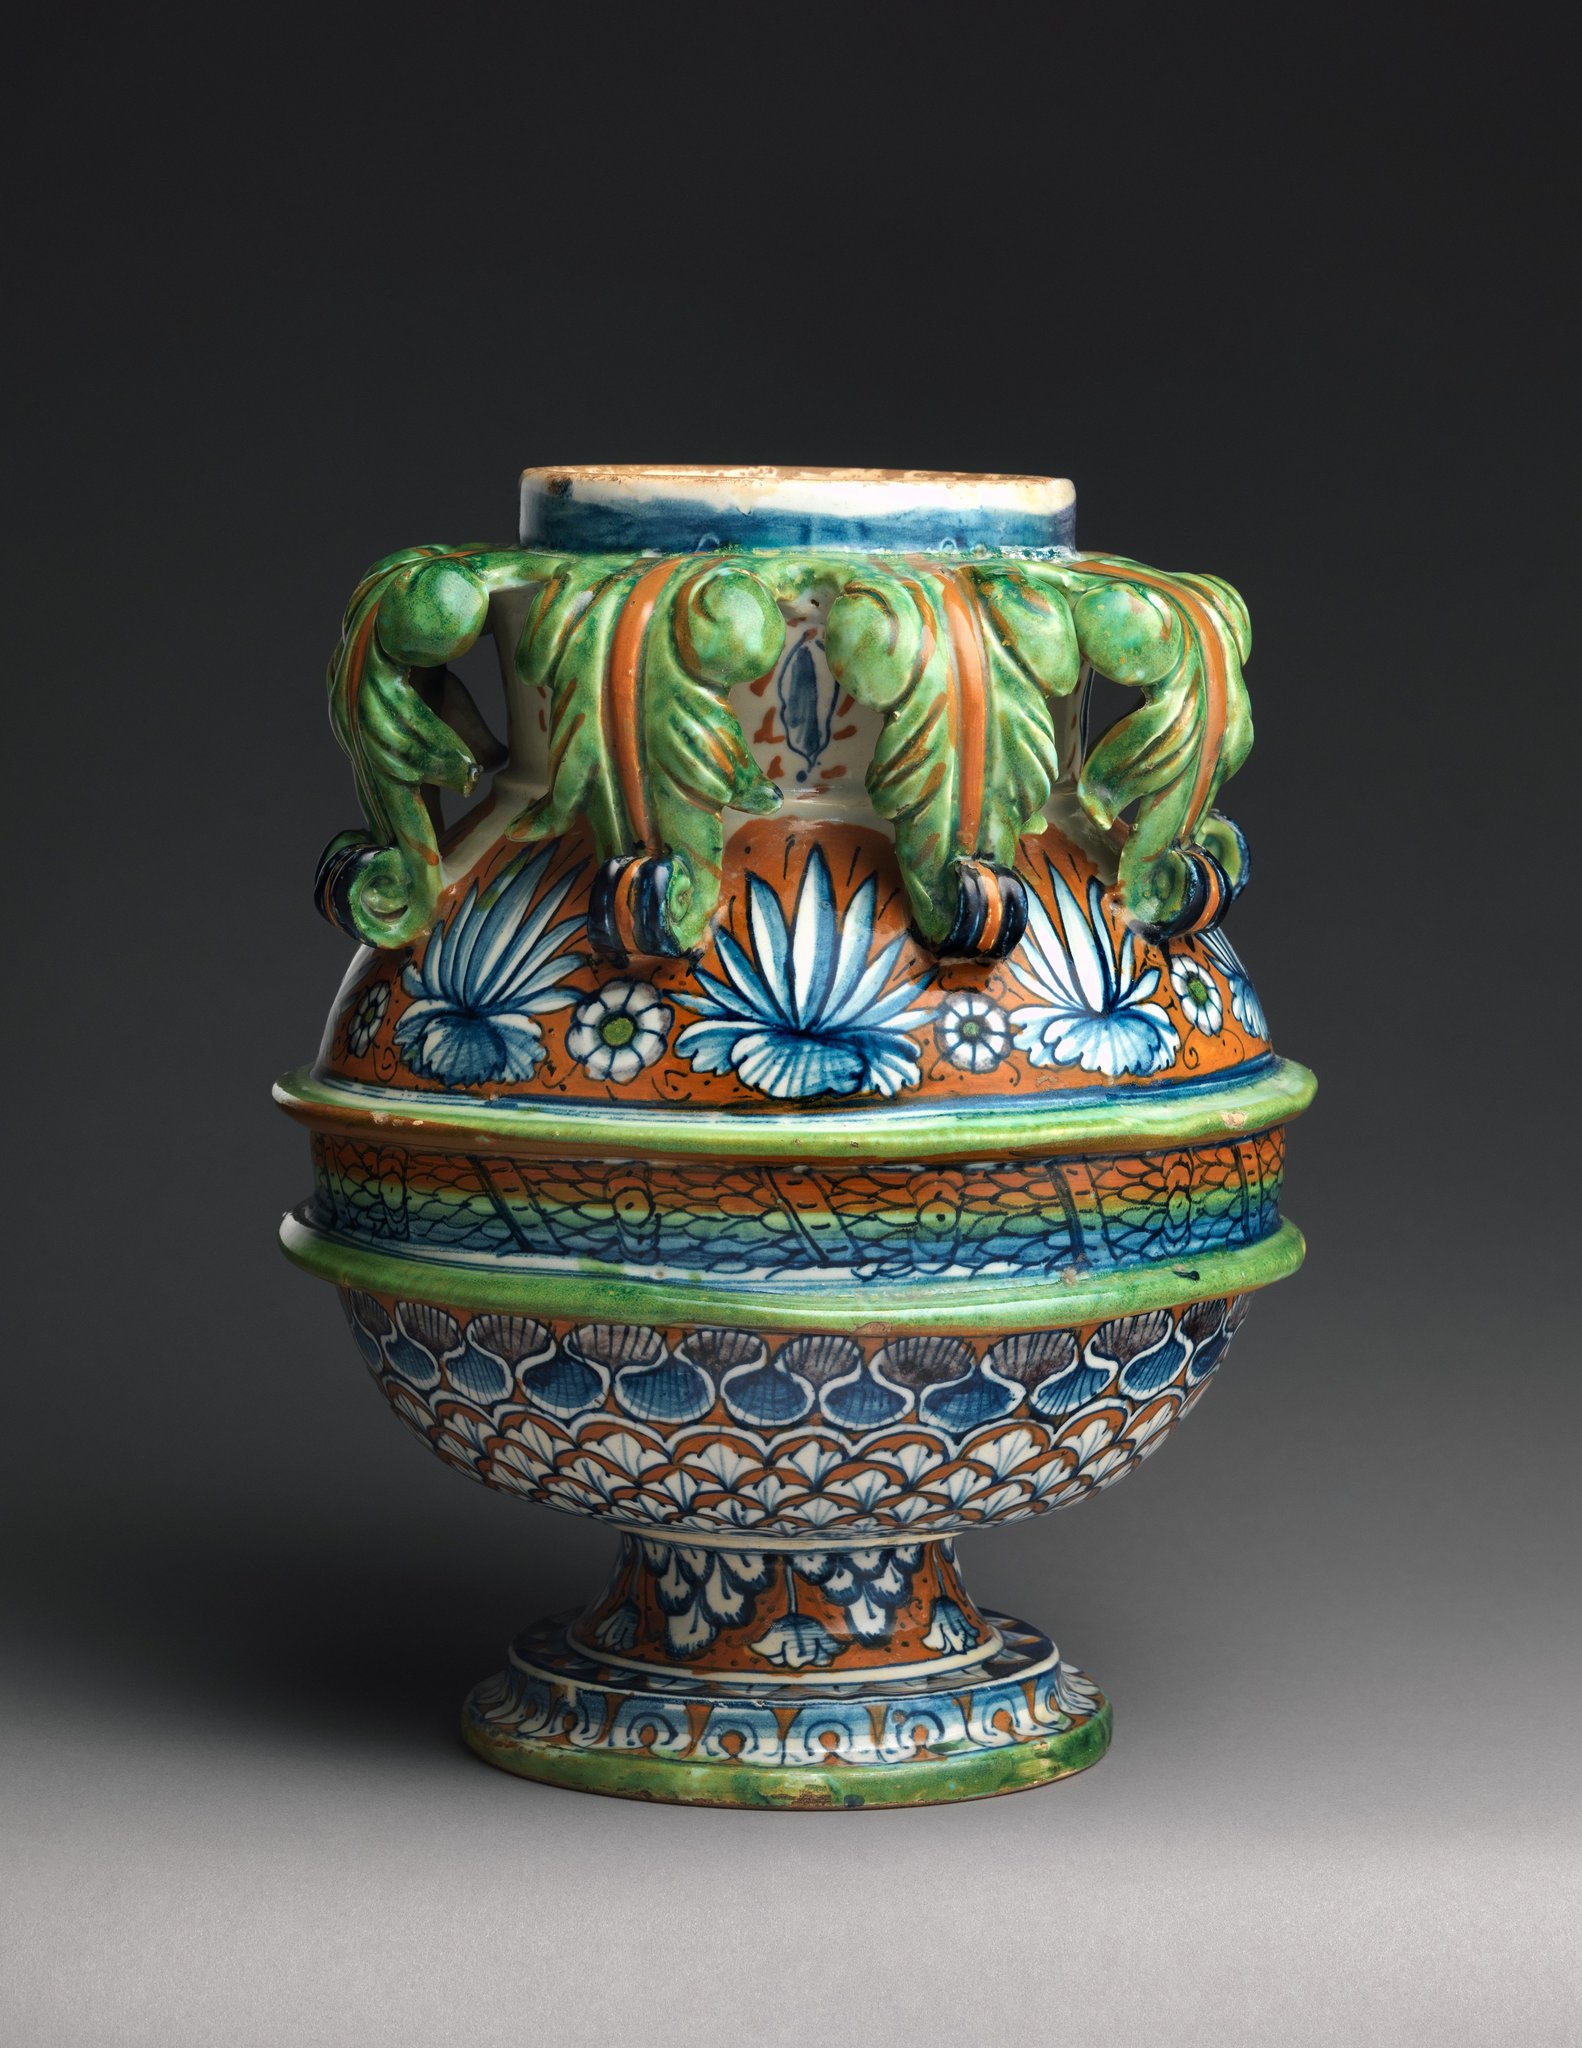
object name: vase or jar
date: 1490-1500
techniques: maiolica, glazing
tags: flowers